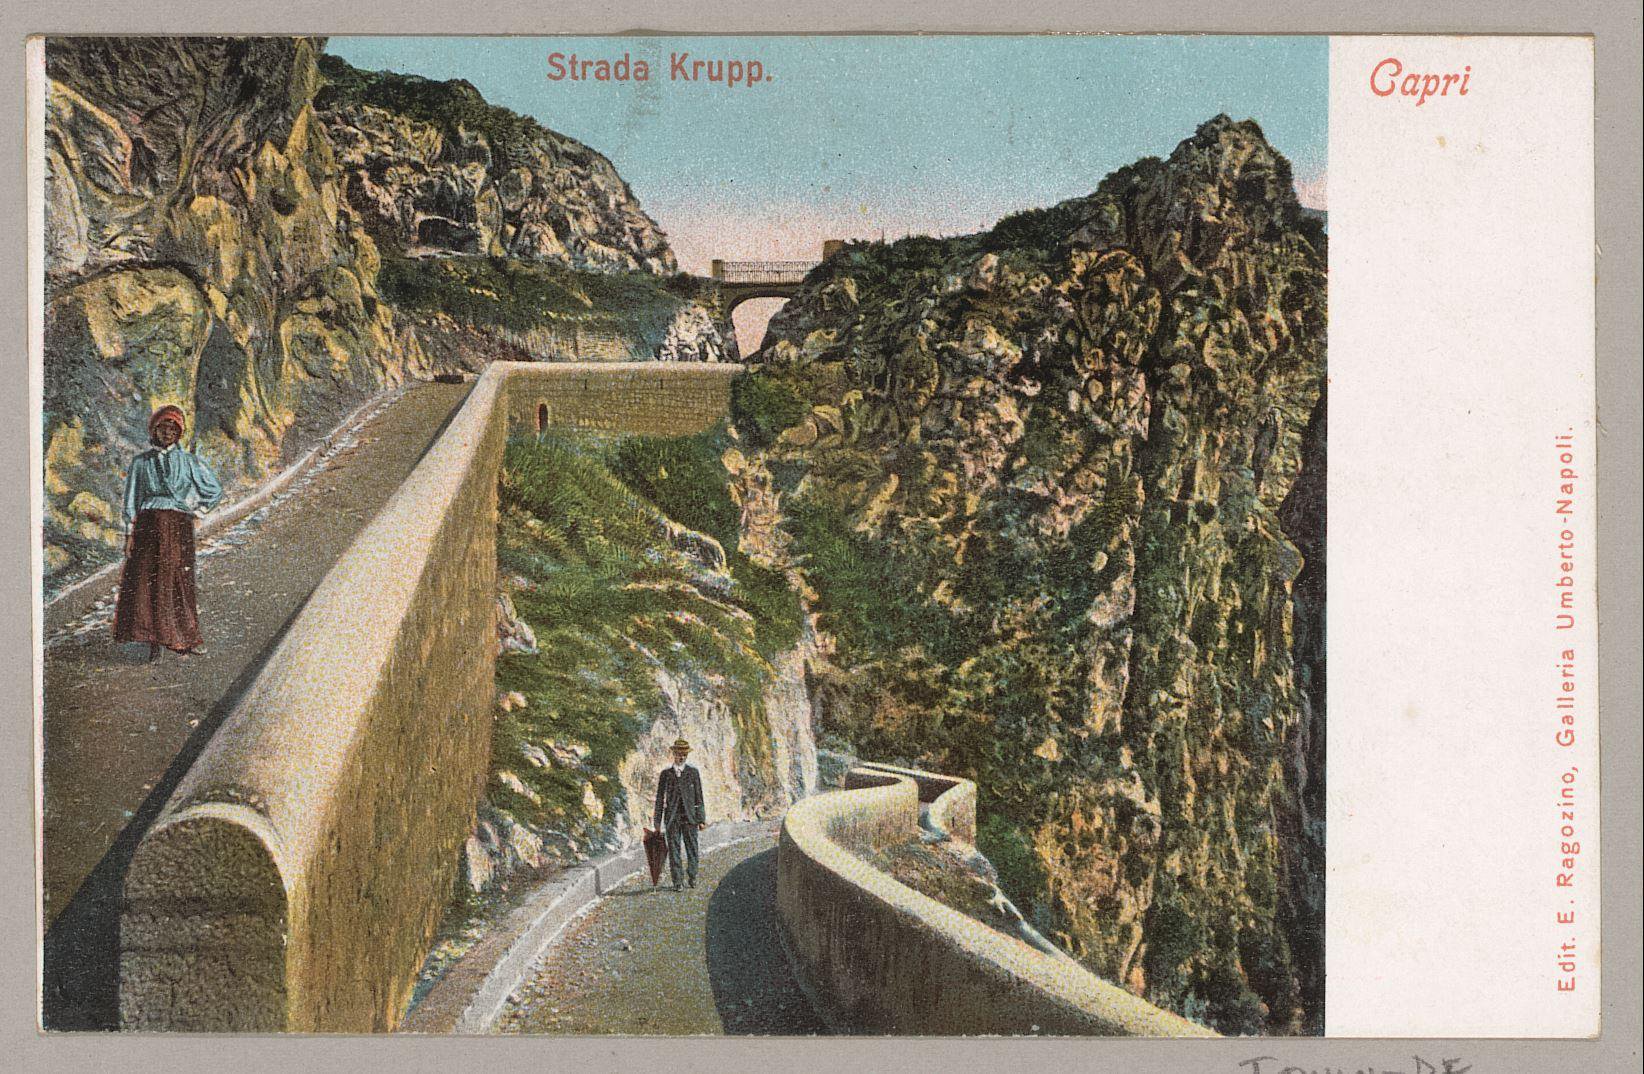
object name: ansichtkaart, prentbriefkaart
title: Capri Strada Krupp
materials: paper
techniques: color autotype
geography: naples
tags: road, path, capri, isola di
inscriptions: name: ‘Edit. E. Ragizino, Galleria Umberto-Napoli’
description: Onderdeel van Fotoalbum van een reis door Zuid-Europa en het Midden-Oosten.